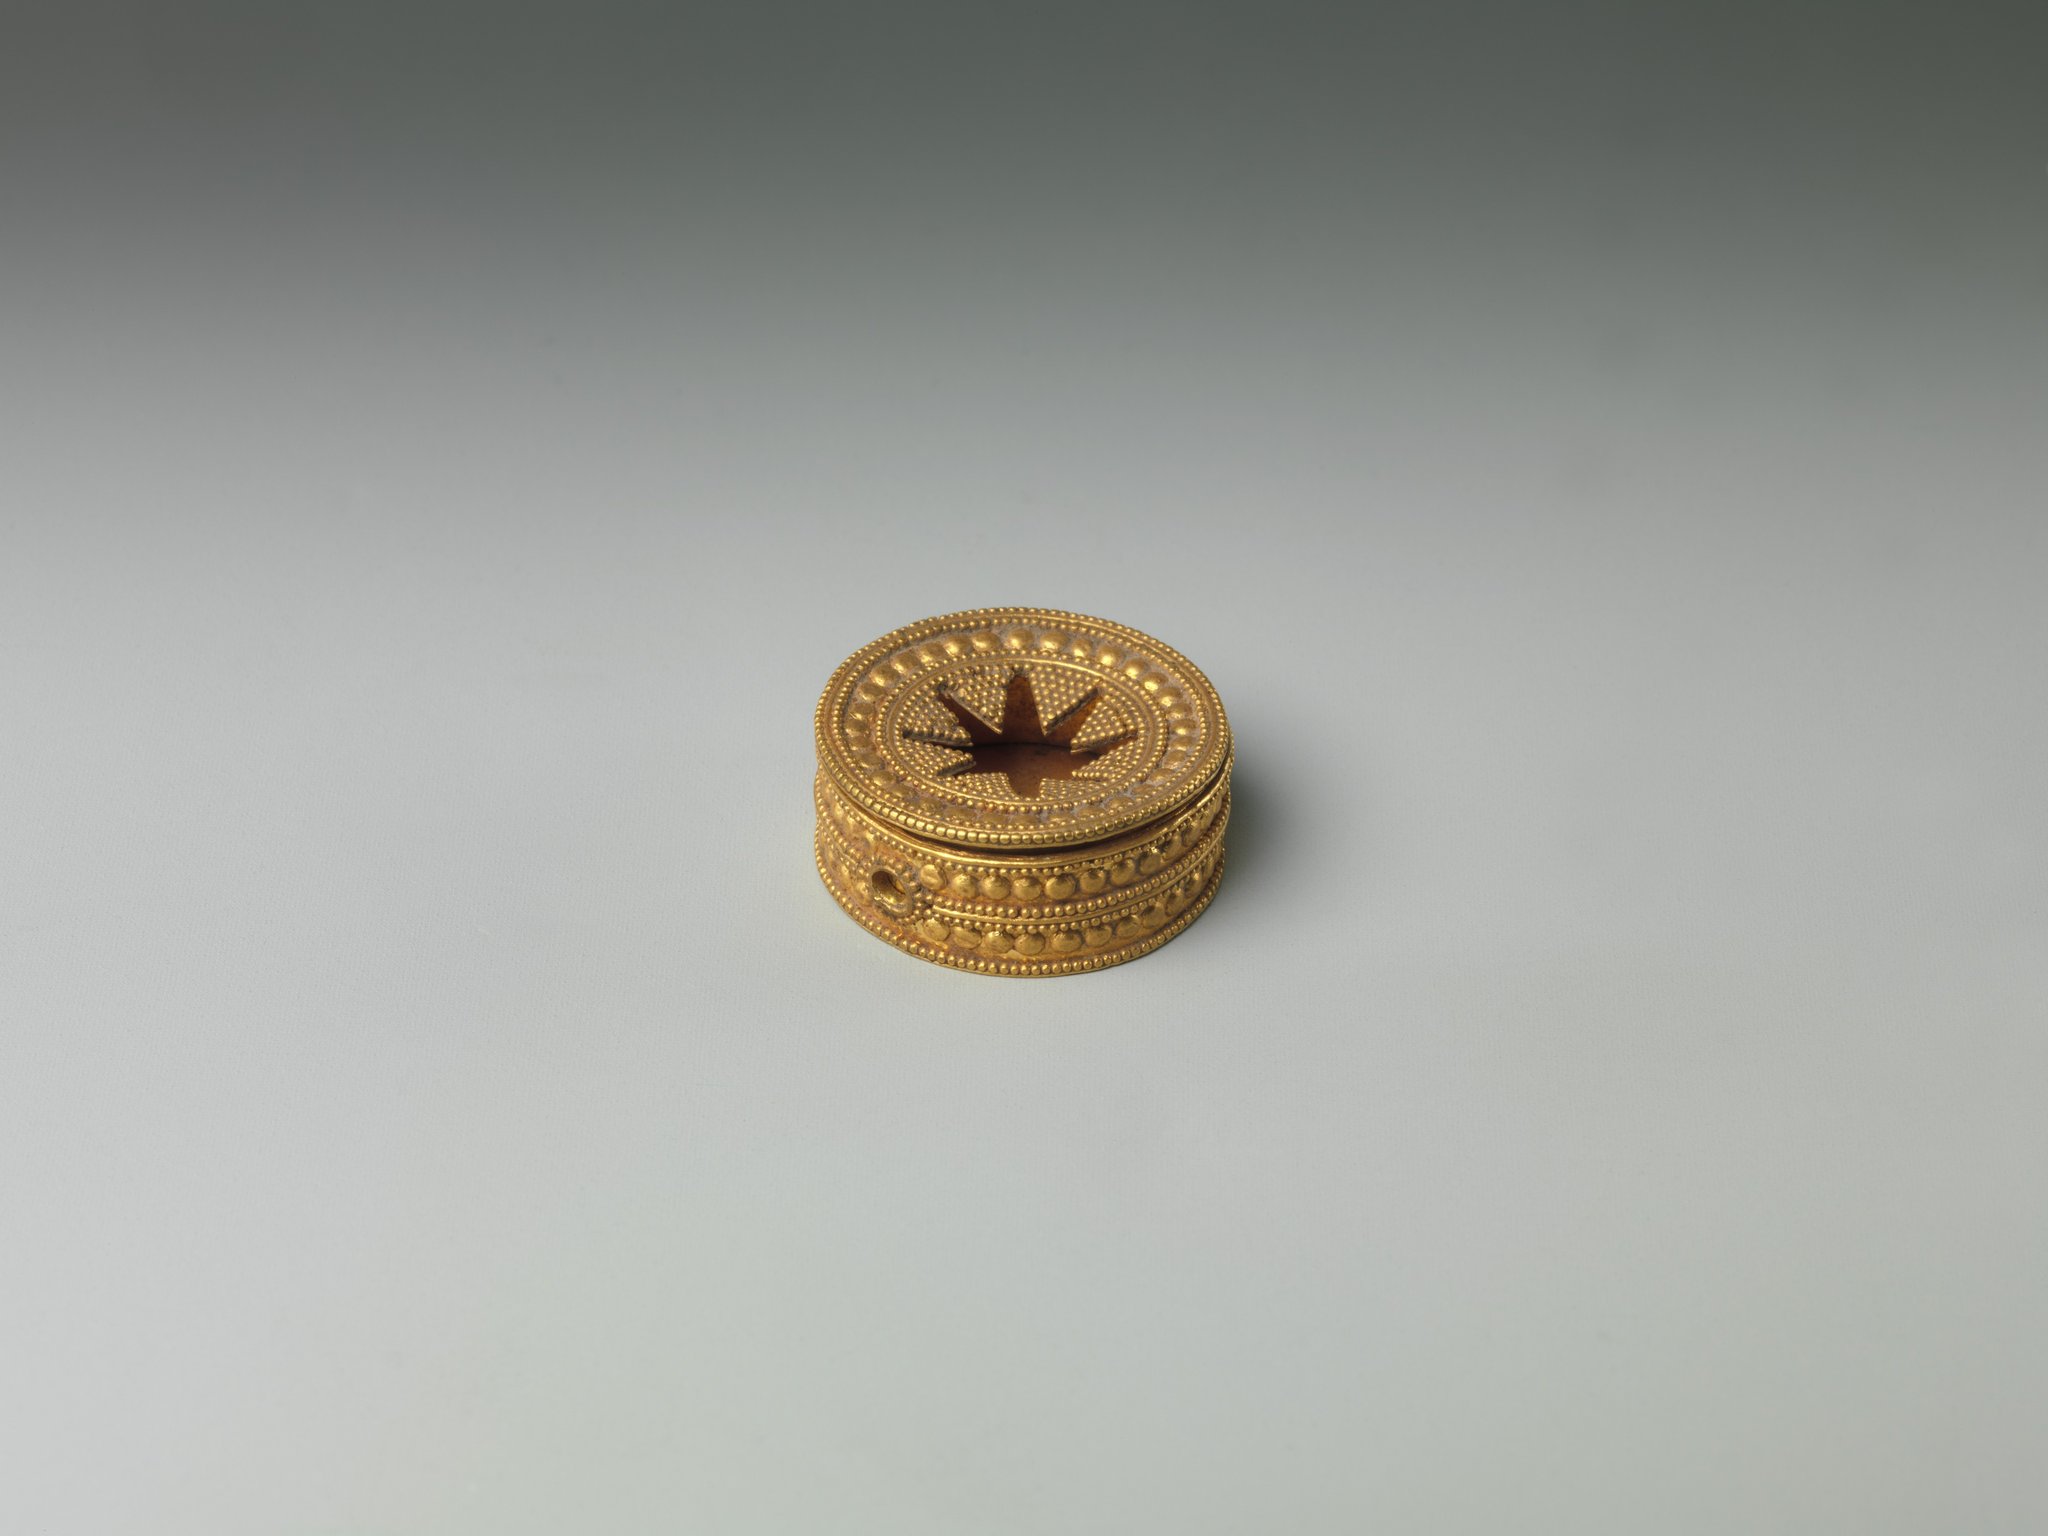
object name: box, granulated, star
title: Box-form ornament with granulation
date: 600-301 BCE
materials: gold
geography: egypt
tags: stars